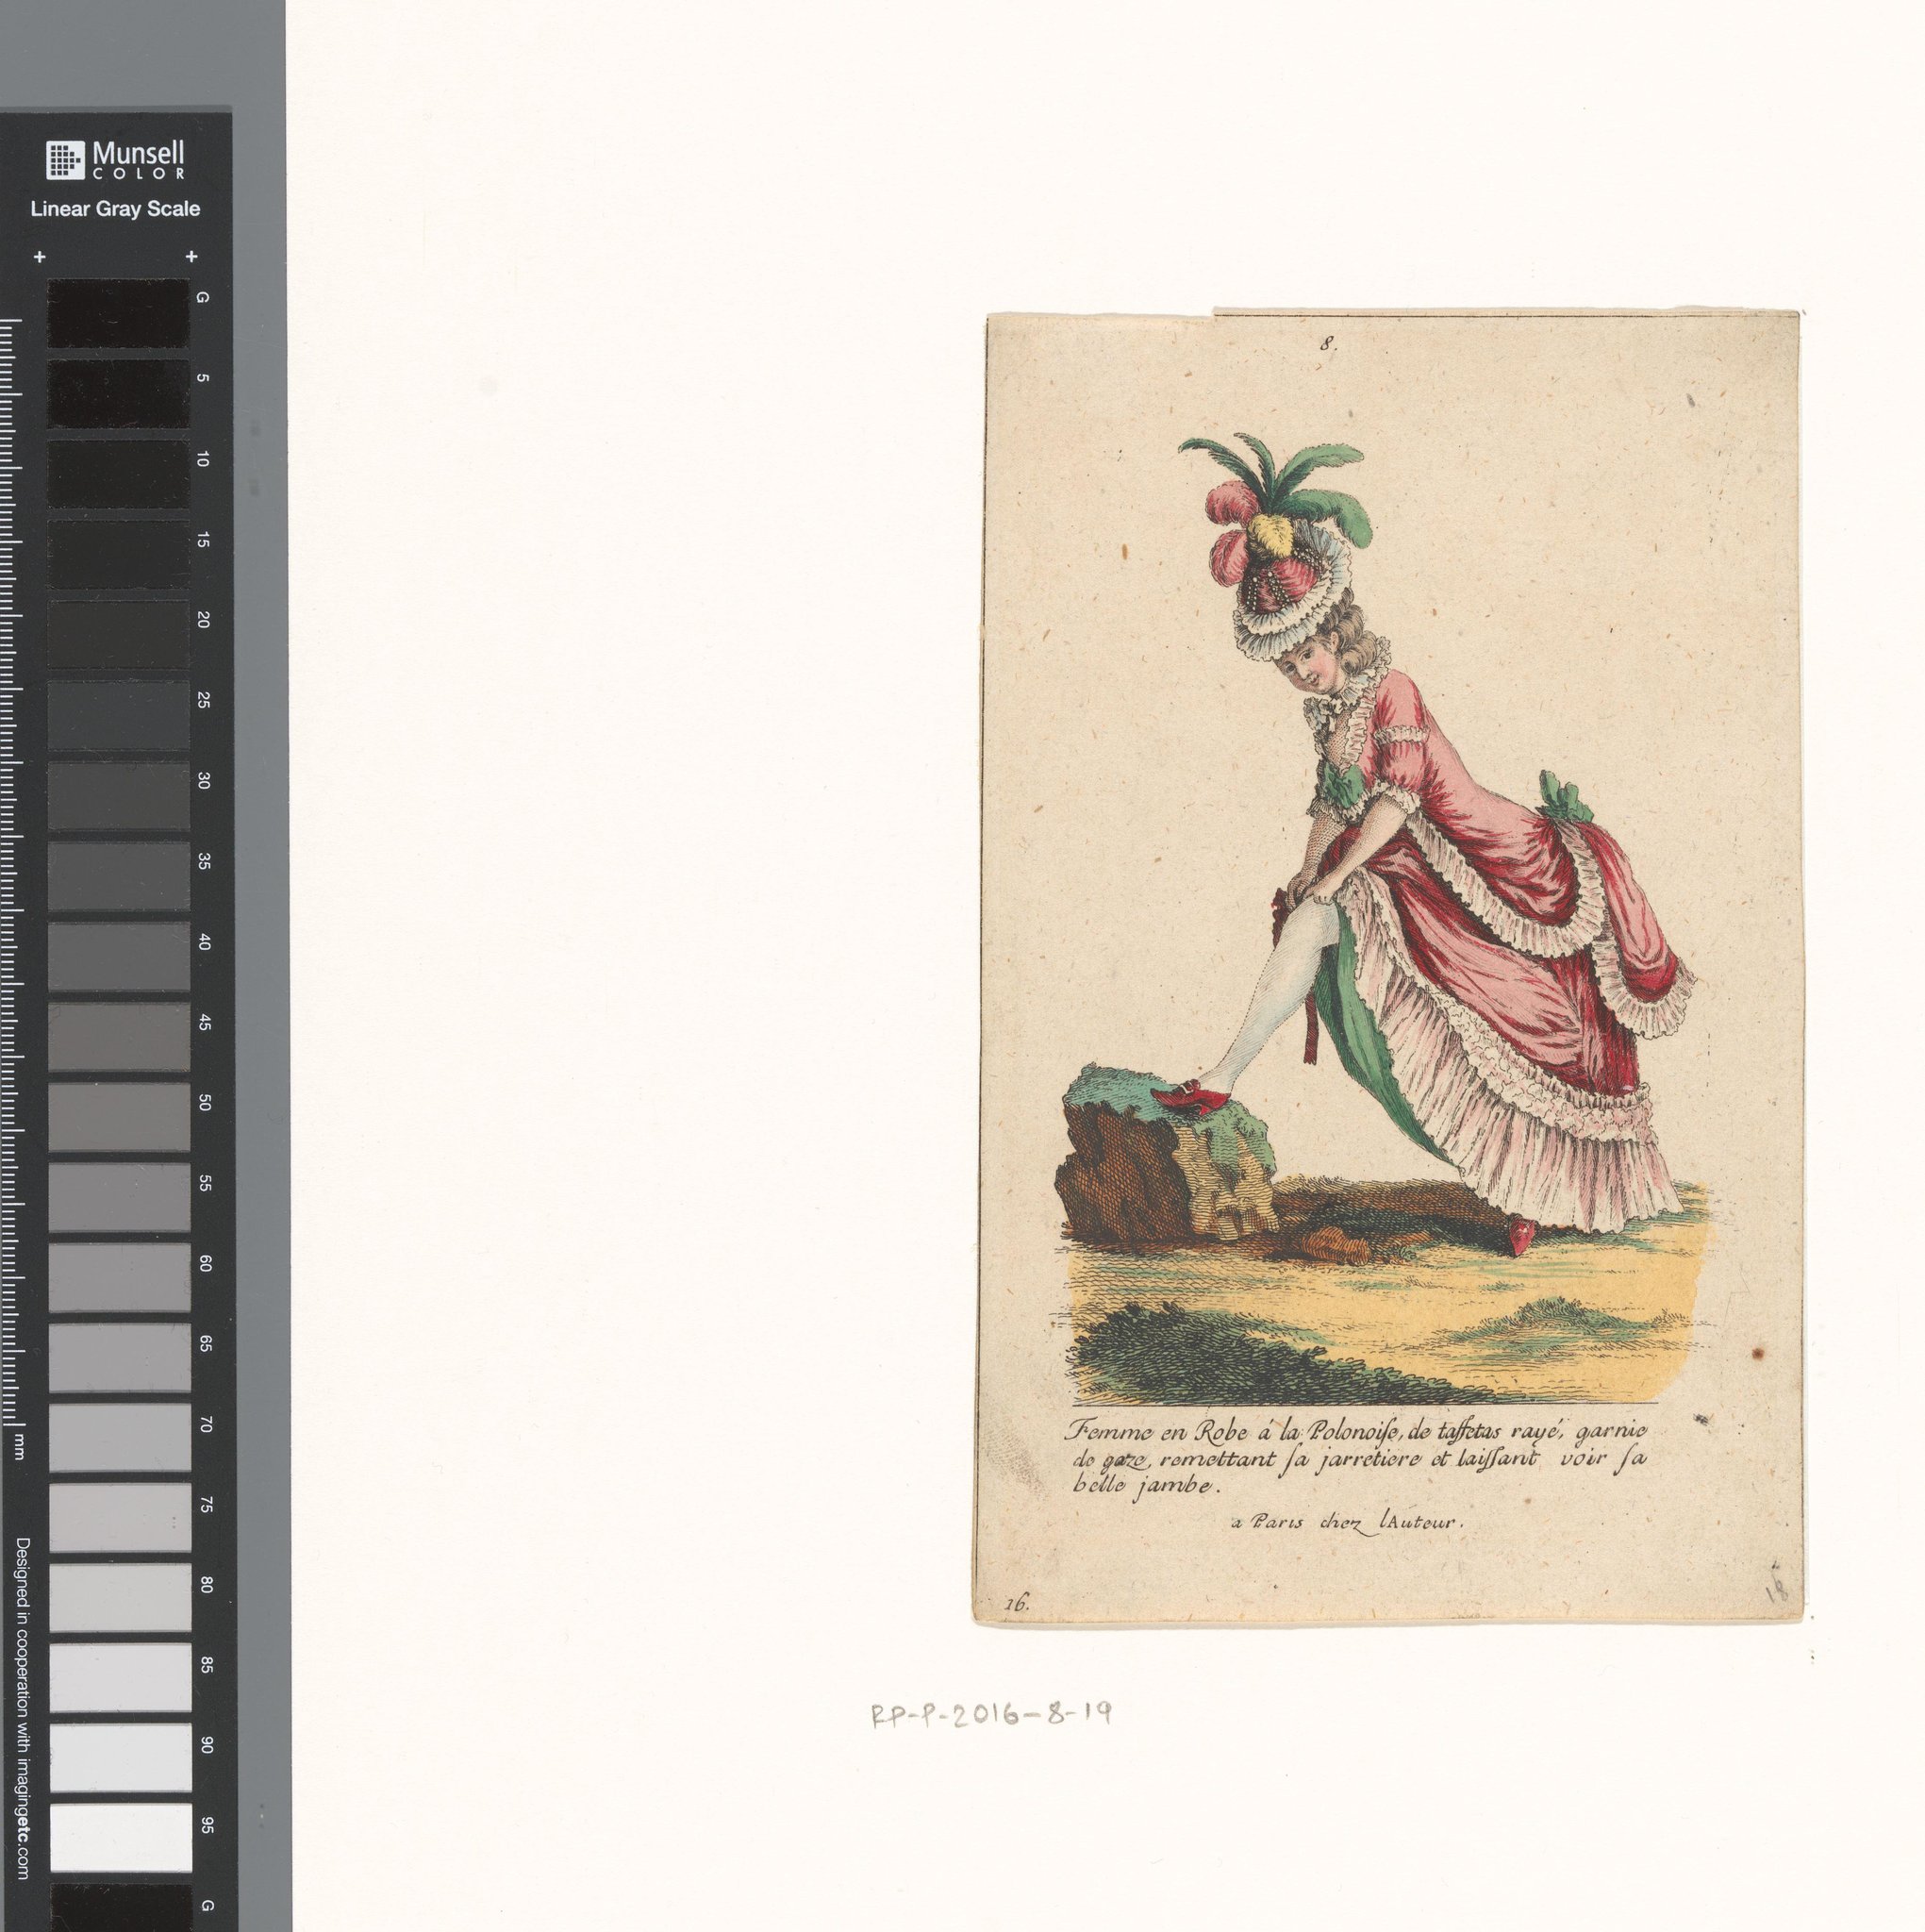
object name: fashion print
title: Gallerie des Modes et Costumes Français, nr...., kopie naar G.37: Femme en Robe à la Polonnois (...)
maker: Anonymous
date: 1785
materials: paper, ink, watercolor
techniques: etching, hand coloring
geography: paris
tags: gloves, mittens (long gloves) (+ women's clothes), fasteners for clothes (+ women's clothes), fashion plates, head-gear: hat (+ women's clothes), shoes, sandals (+ women's clothes), stockings, socks (+ women's clothes), dress, gown: robe à la polonaise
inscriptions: address: ‘A Paris chez l'Auteur’, collector's mark: Lugt 2228, caption (possibly false): ‘Femme en Robe à la Polonoise, de tafetas rayé, garnie de gaze, remettant sa jarretière, et laissant voir sa belle jambe.’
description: Jonge vrouw die haar kous met een kousenband vastzet en zo een deel van haar (mooi gevormde) been toont. Ze is gekleed in een robe à la Polonaise, afgezet met tafzijde. Kleine ronde hoed met veren. Verkleinde kopie naar G.37 uit serie G. 7e Cahier des Costumes Francais, 1ere Suite d'Habillemens de Femmes à la Mode, Gallerie des Modes et Costumes Français,